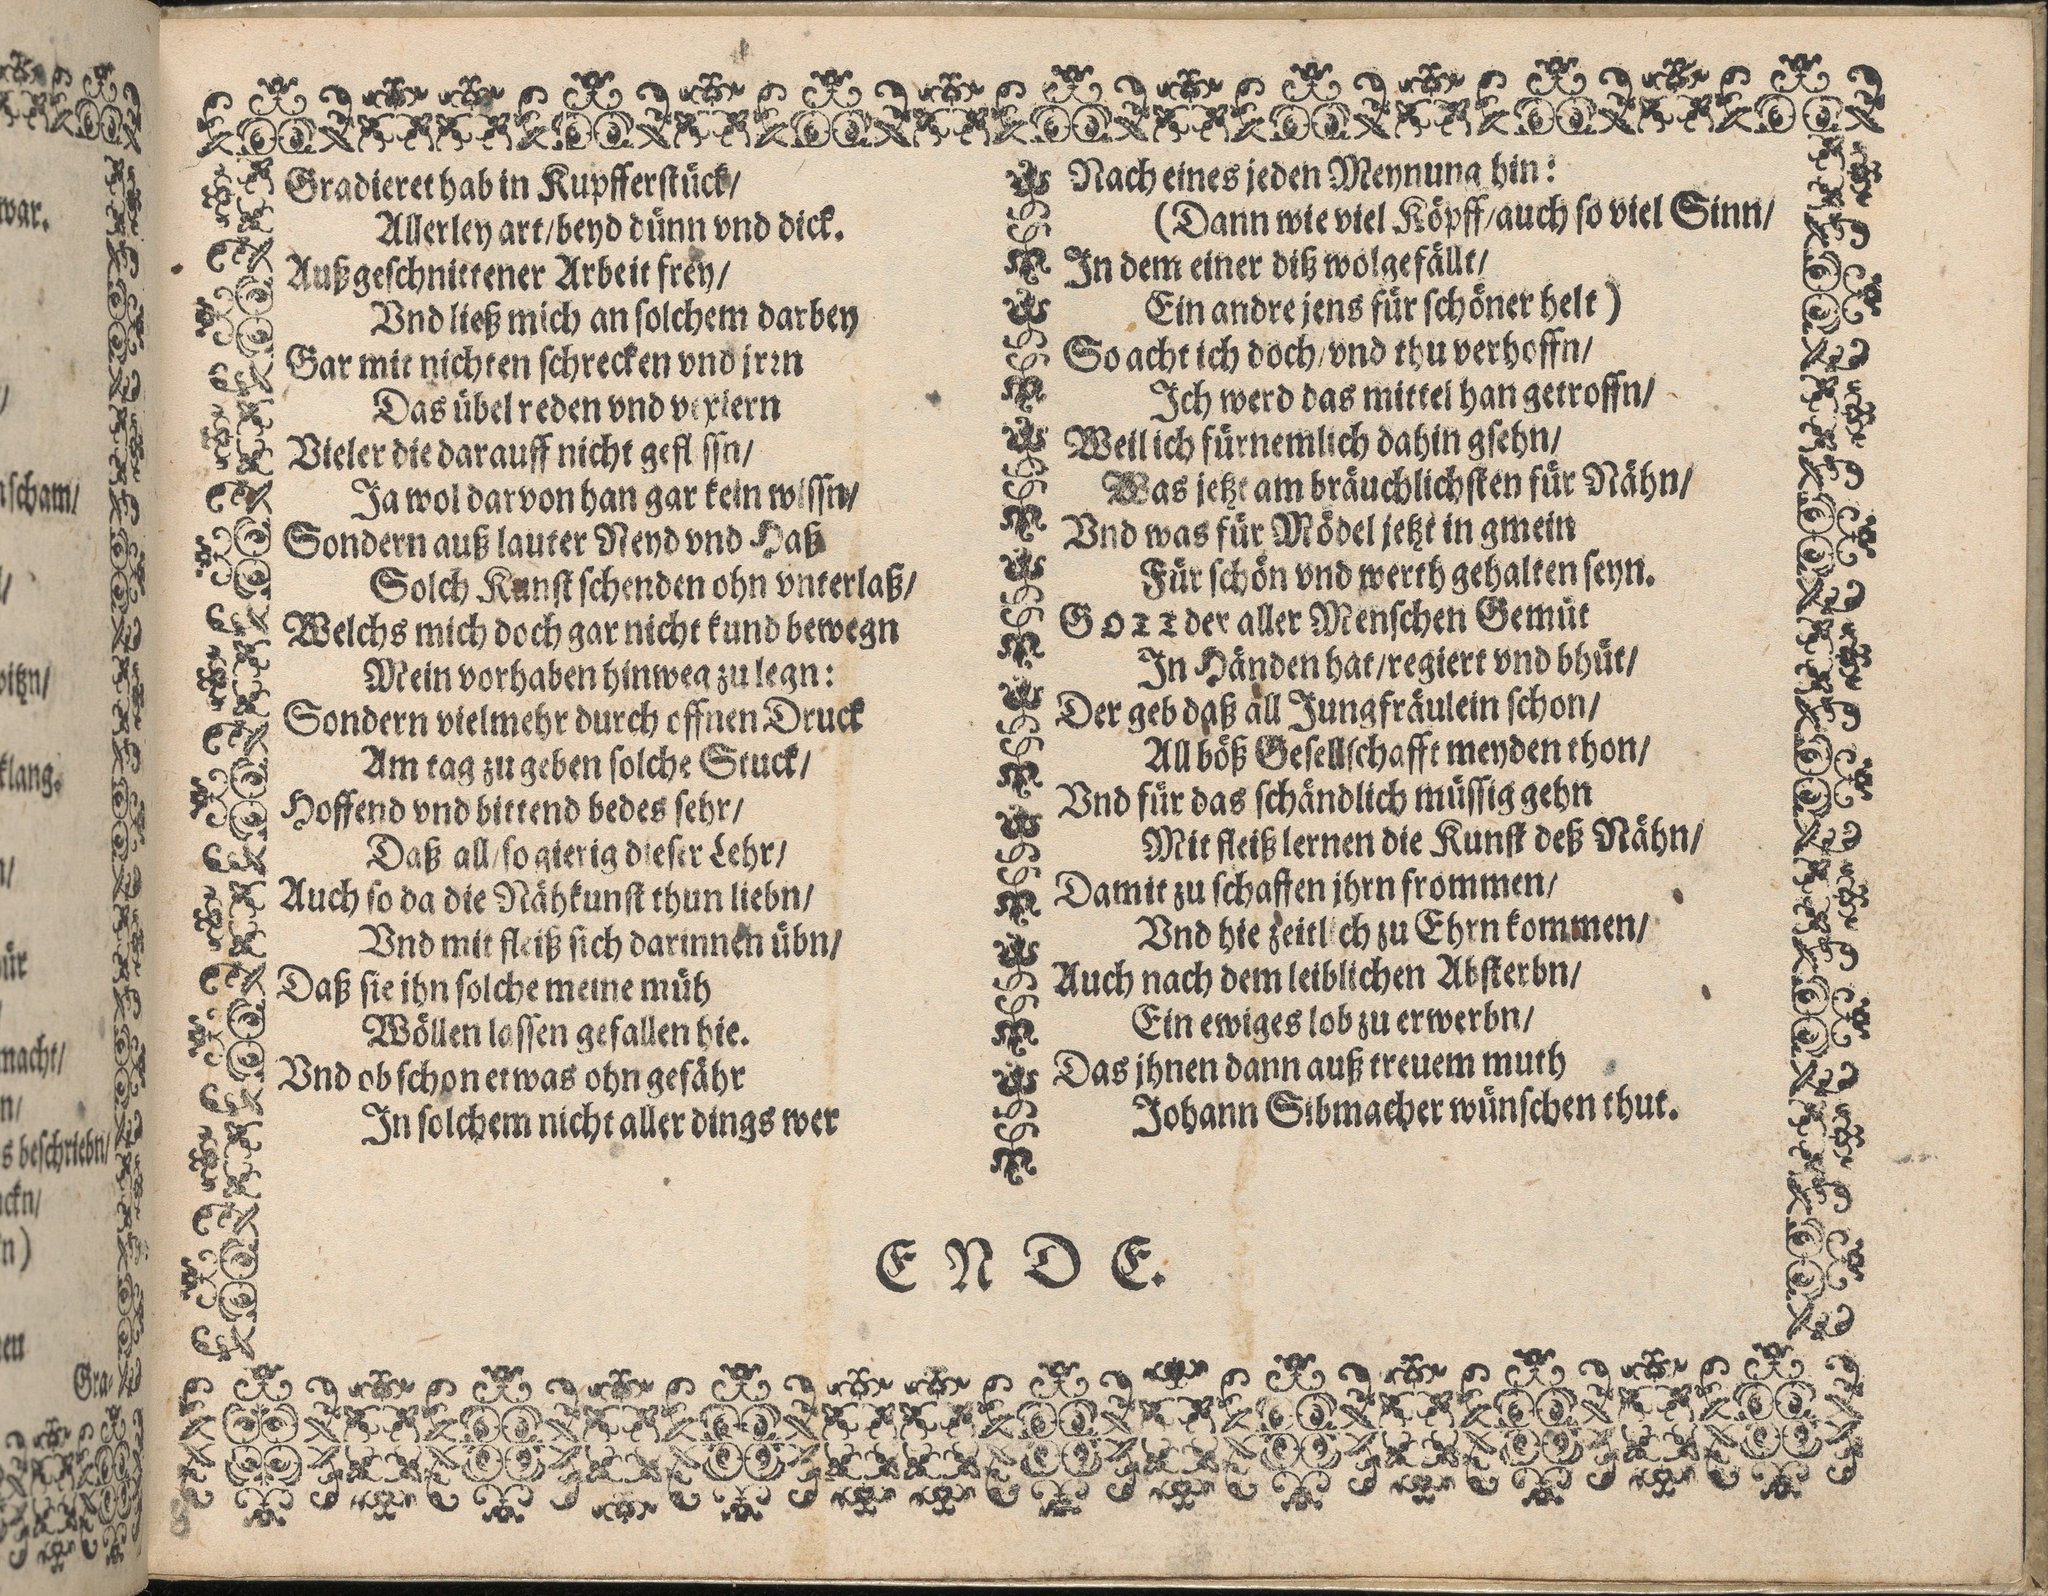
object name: book print ornament architecture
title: Newes Modelbuch in Kupffer (Page 8r)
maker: johann sibmacher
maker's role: artist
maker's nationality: german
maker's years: 1590-1611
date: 1604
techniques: woodcut